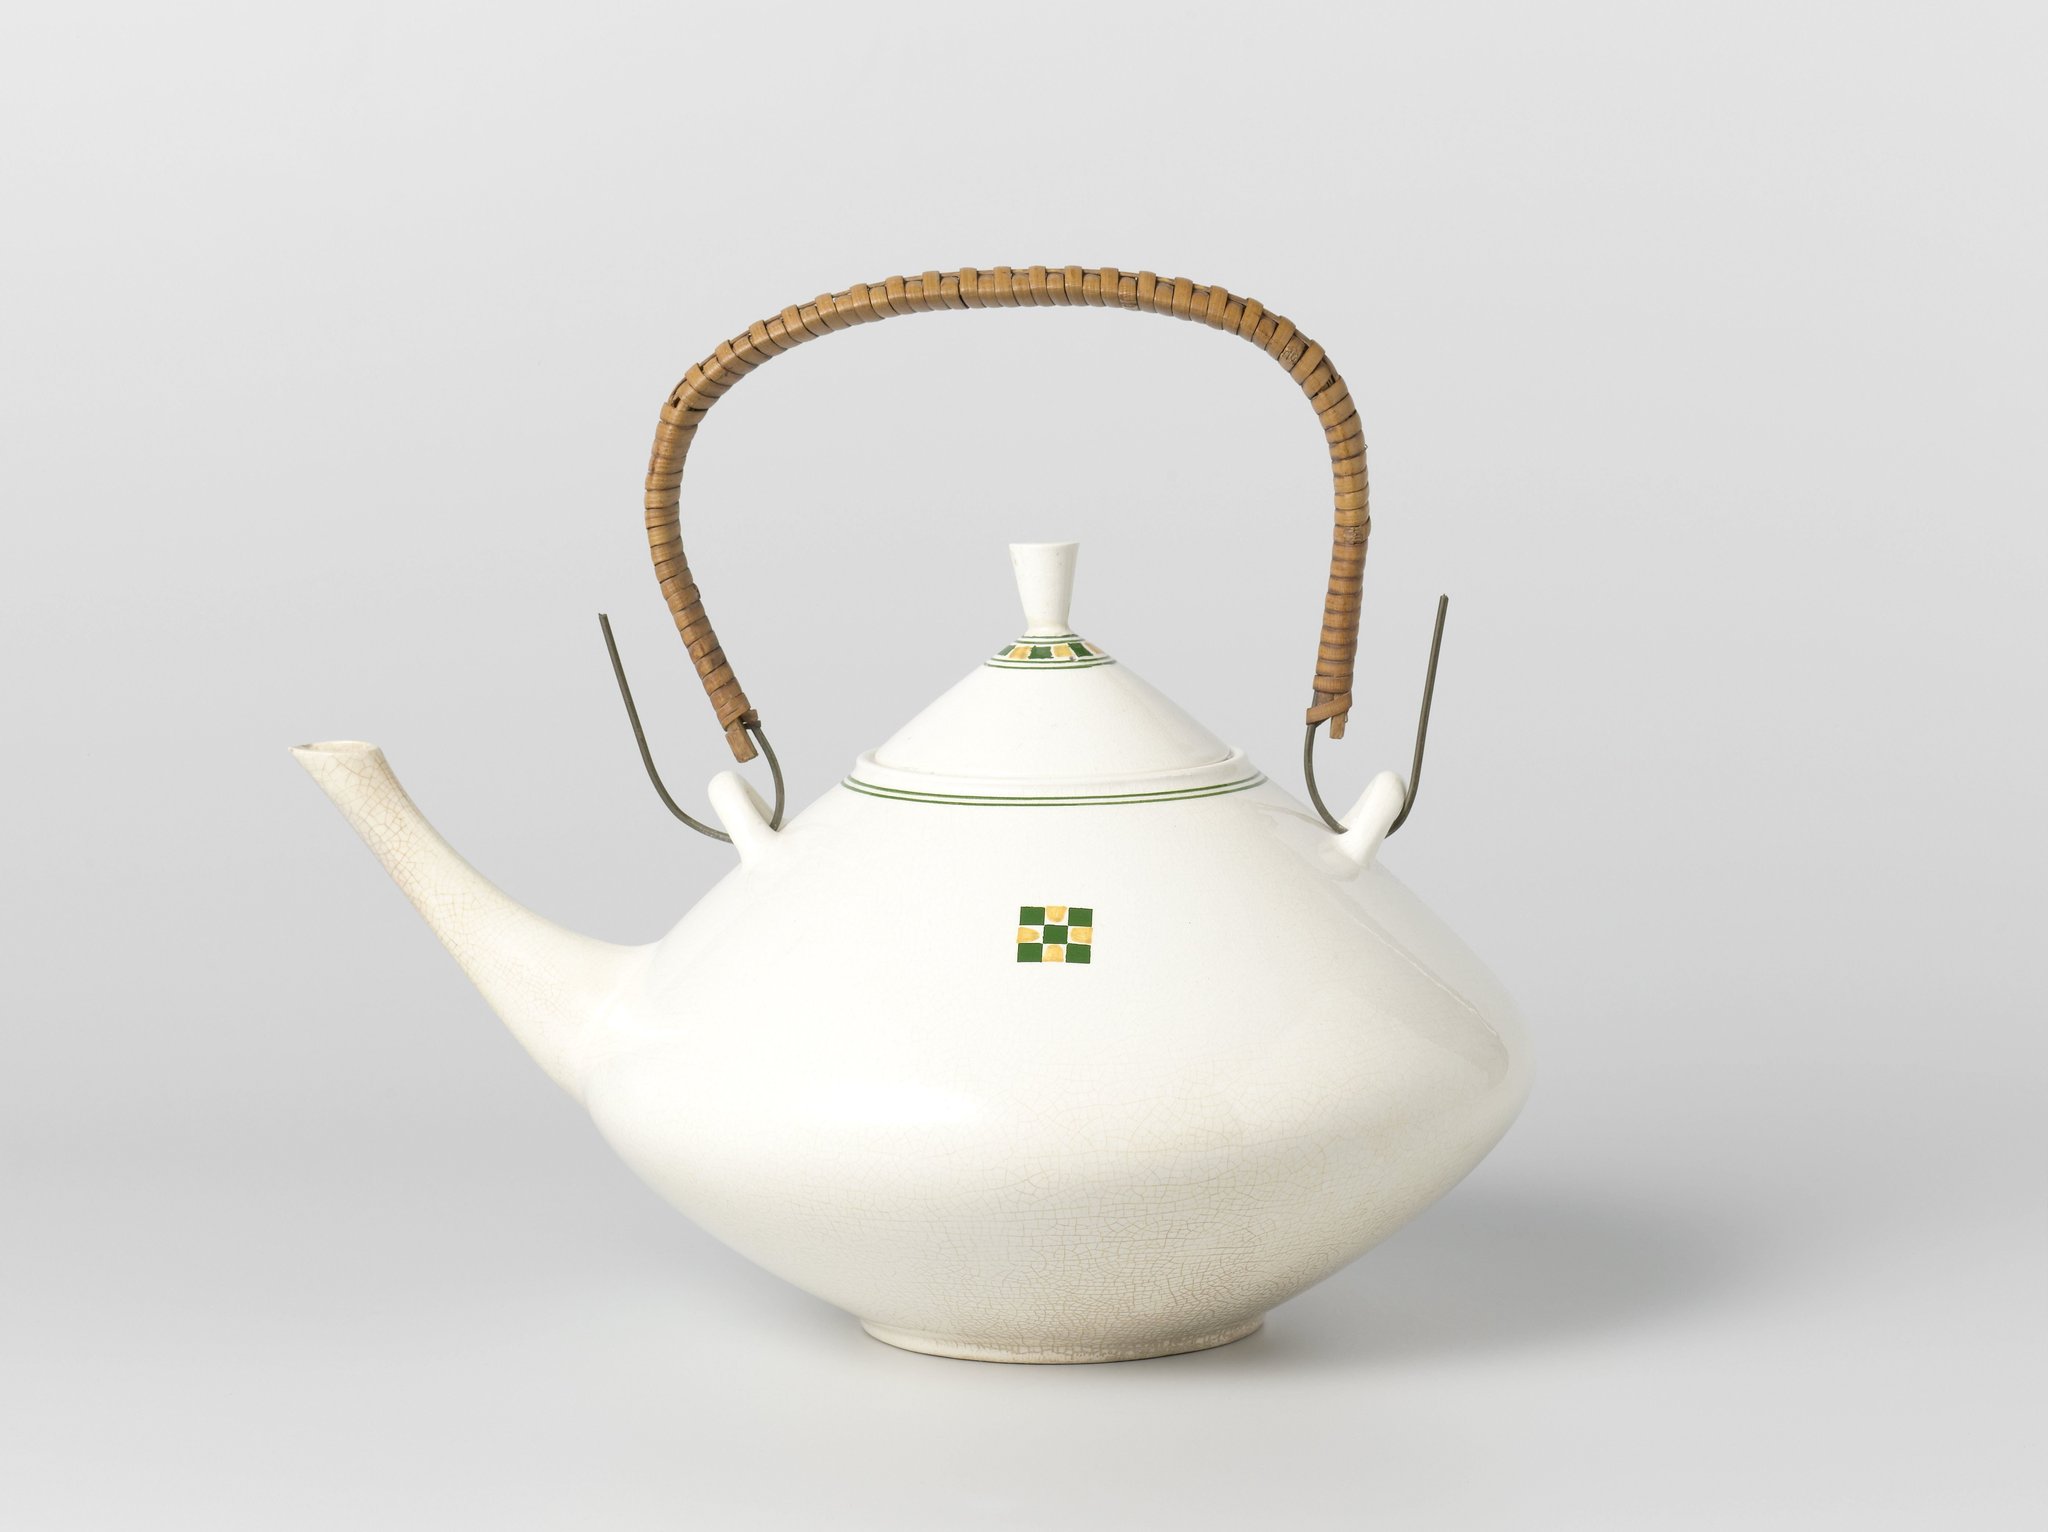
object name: teakettle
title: Theeketel met deksel van aardewerk versierd met groene en gele vierkanten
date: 1910-1920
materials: earthenware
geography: gouda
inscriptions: mark: ‘PLATEELBAKKERIJ.ZUID.HOLLAND ; een poort waarop staat GOUDA ; P // 4048. // A.’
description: Theeketel van aardewerk, versierd met groene en gele vierkanten en een dubbele groen bies langs de randen. De ketel heeft een lange tuit en een met riet omwonden hengsel. Bijbehorende koppen en schotels (bk-1972-135-B,C).